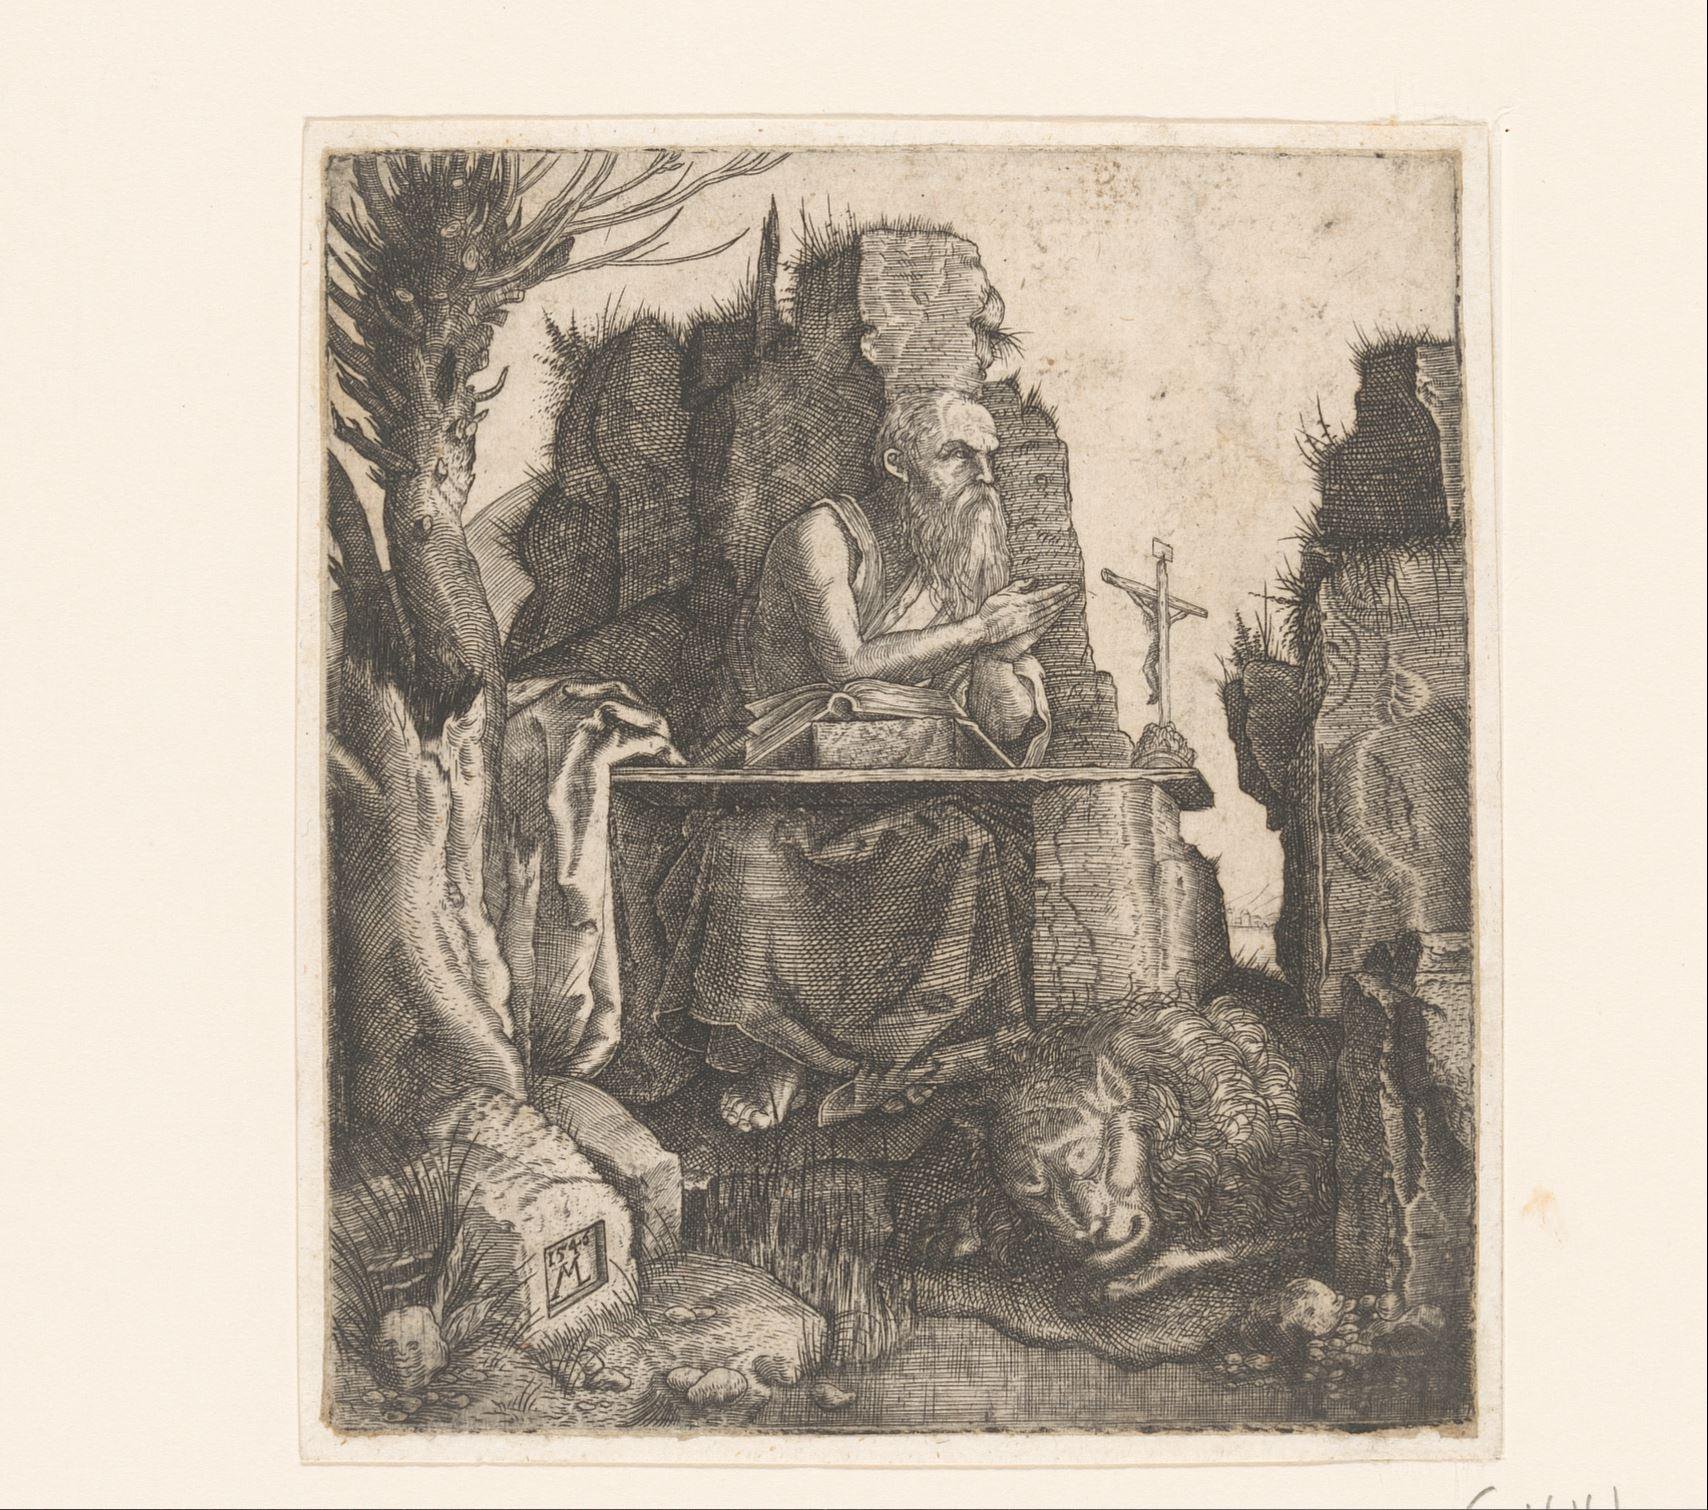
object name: print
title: H. Hieronymus en de leeuw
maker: melchior lorck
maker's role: draughtsman, painter, print maker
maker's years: 1526-1588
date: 1546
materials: paper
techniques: engraving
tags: the monk and hermit jerome (hieronymus); possible attributes: book, cardinal's hat, crucifix, hour-glass, lion, skull, stone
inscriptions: collector's mark: Lugt 240